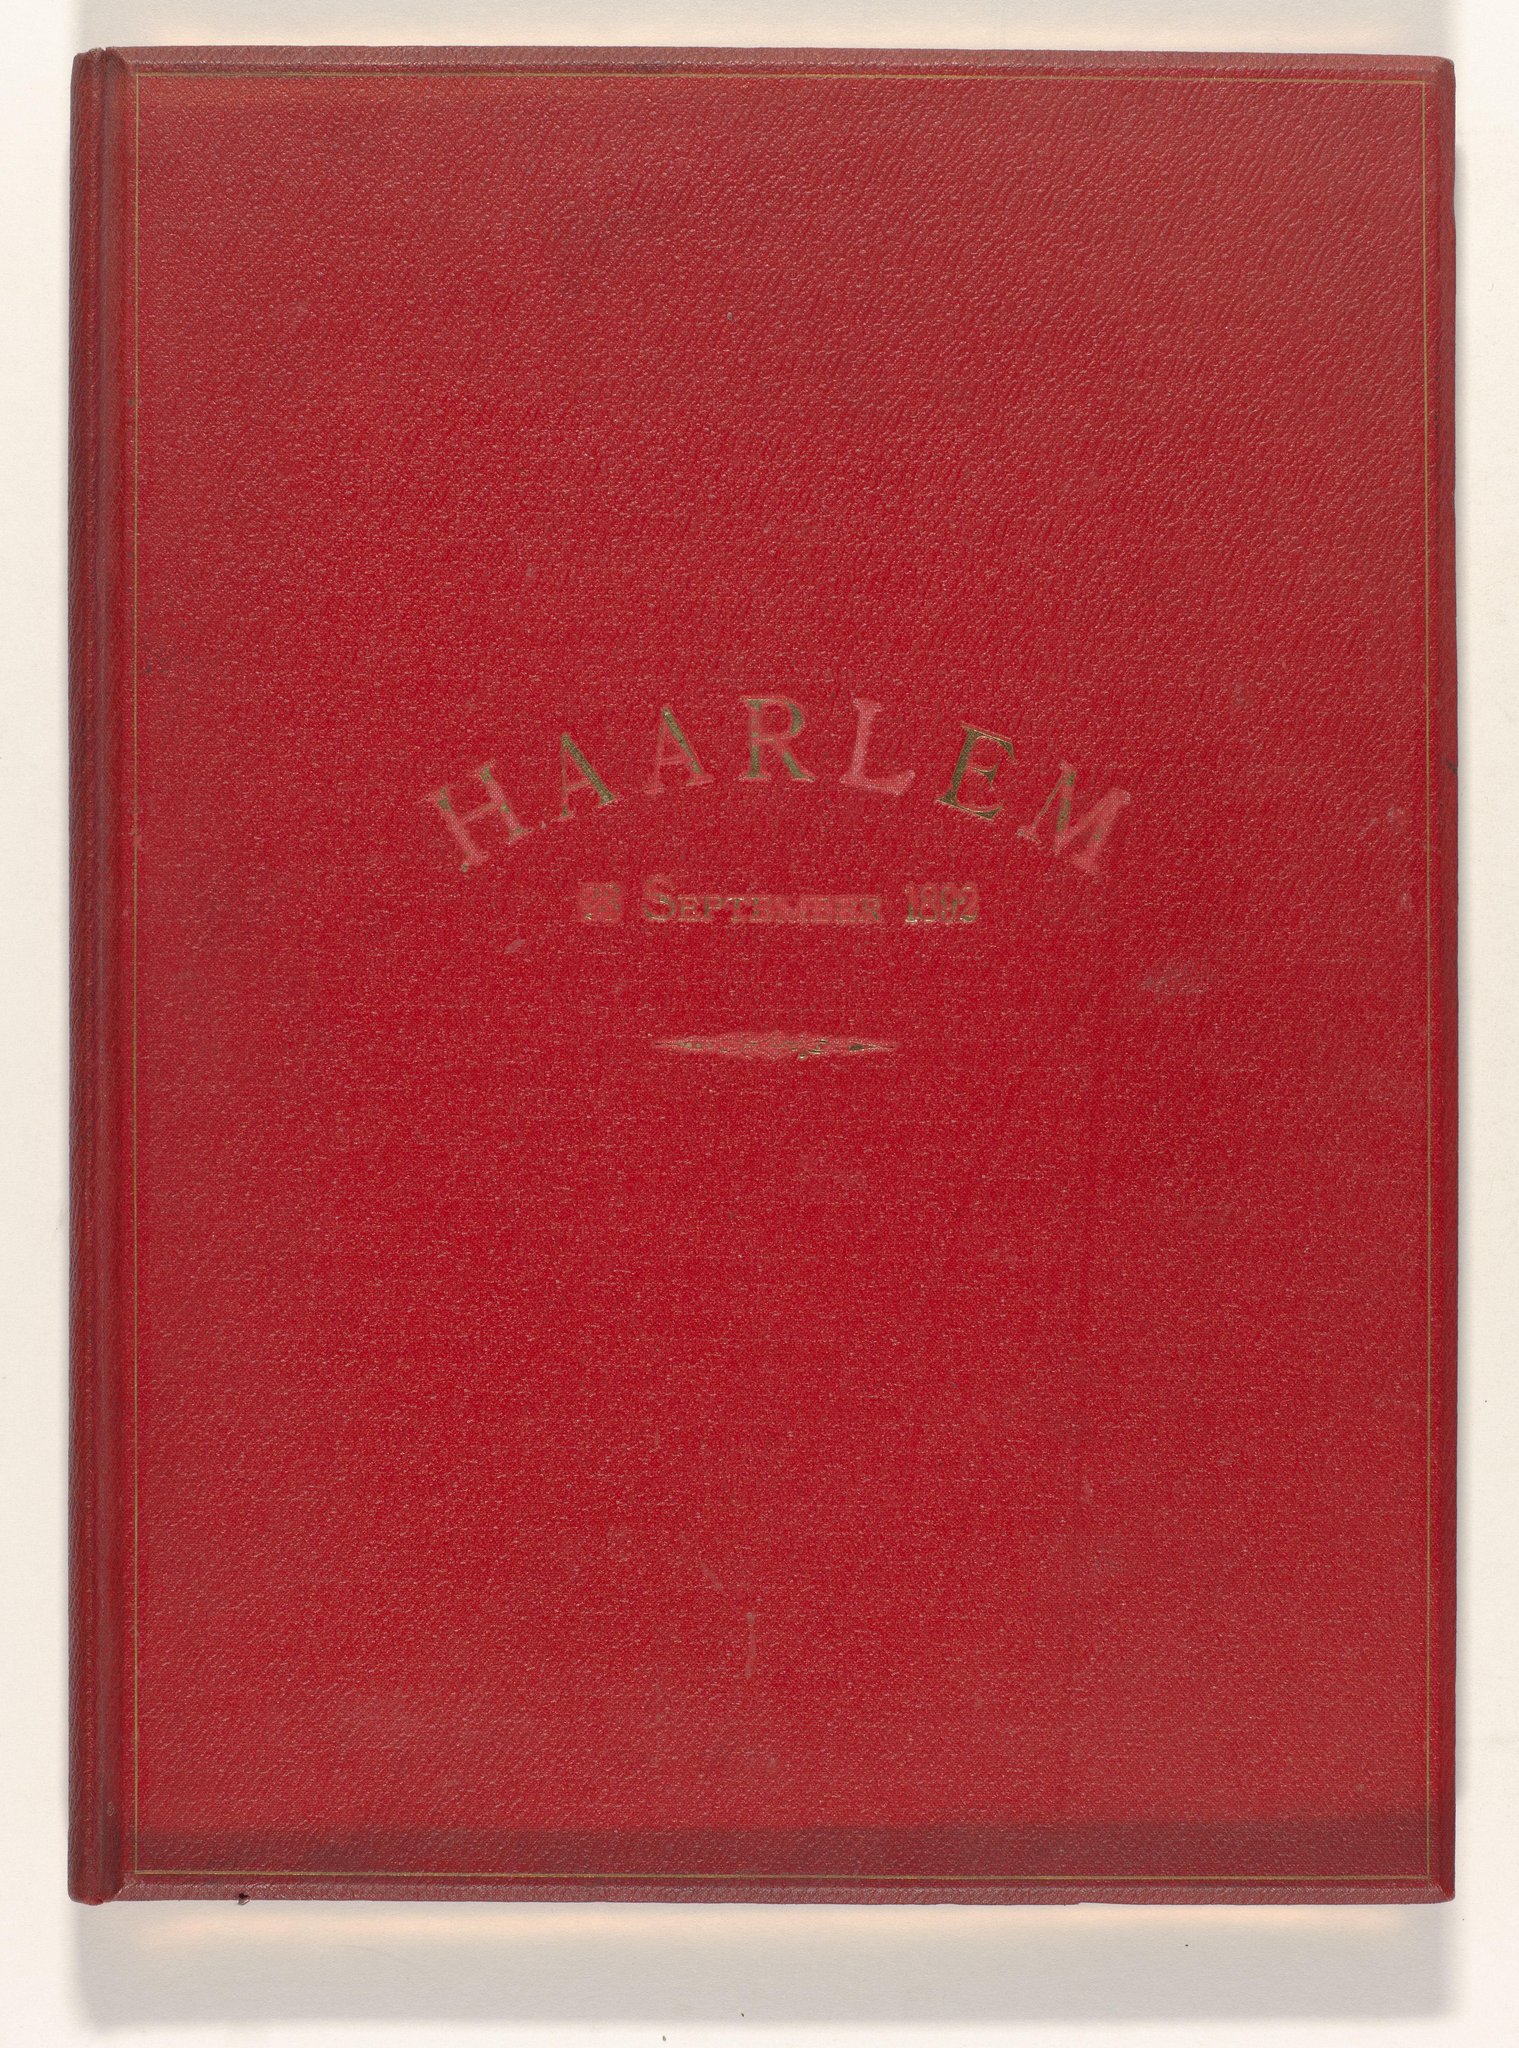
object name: scrapbook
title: Herdenkingsalbum ter gelegenheid van het bezoek van koningin-regentes Emma aan Haarlem op 23 september 1892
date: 1892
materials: cardboard, linen, paper, photographic support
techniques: albumen print, printing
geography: haarlem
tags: triumphal arch, public festivities, haarlem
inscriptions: collector's mark: ‘DIENST/ VERSPREIDE/ RIJKSKOLLEKTIES/ (...) F01065’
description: Fotoalbum met negen bladen met in totaal drie foto's. Het album is gemaakt ter herinnering aan het bezoek van koningin-regentes Emma aan Haarlem op 23 september 1892. Afgebeeld zijn een ereboog en een erepoort die voor de gelegenheid in Haarlem zijn geplaatst en een fotoreproductie van het interieur van de Ridderzaal in het Raadhuis in Haarlem. De foto's zijn gemaakt door een anonieme fotograaf.